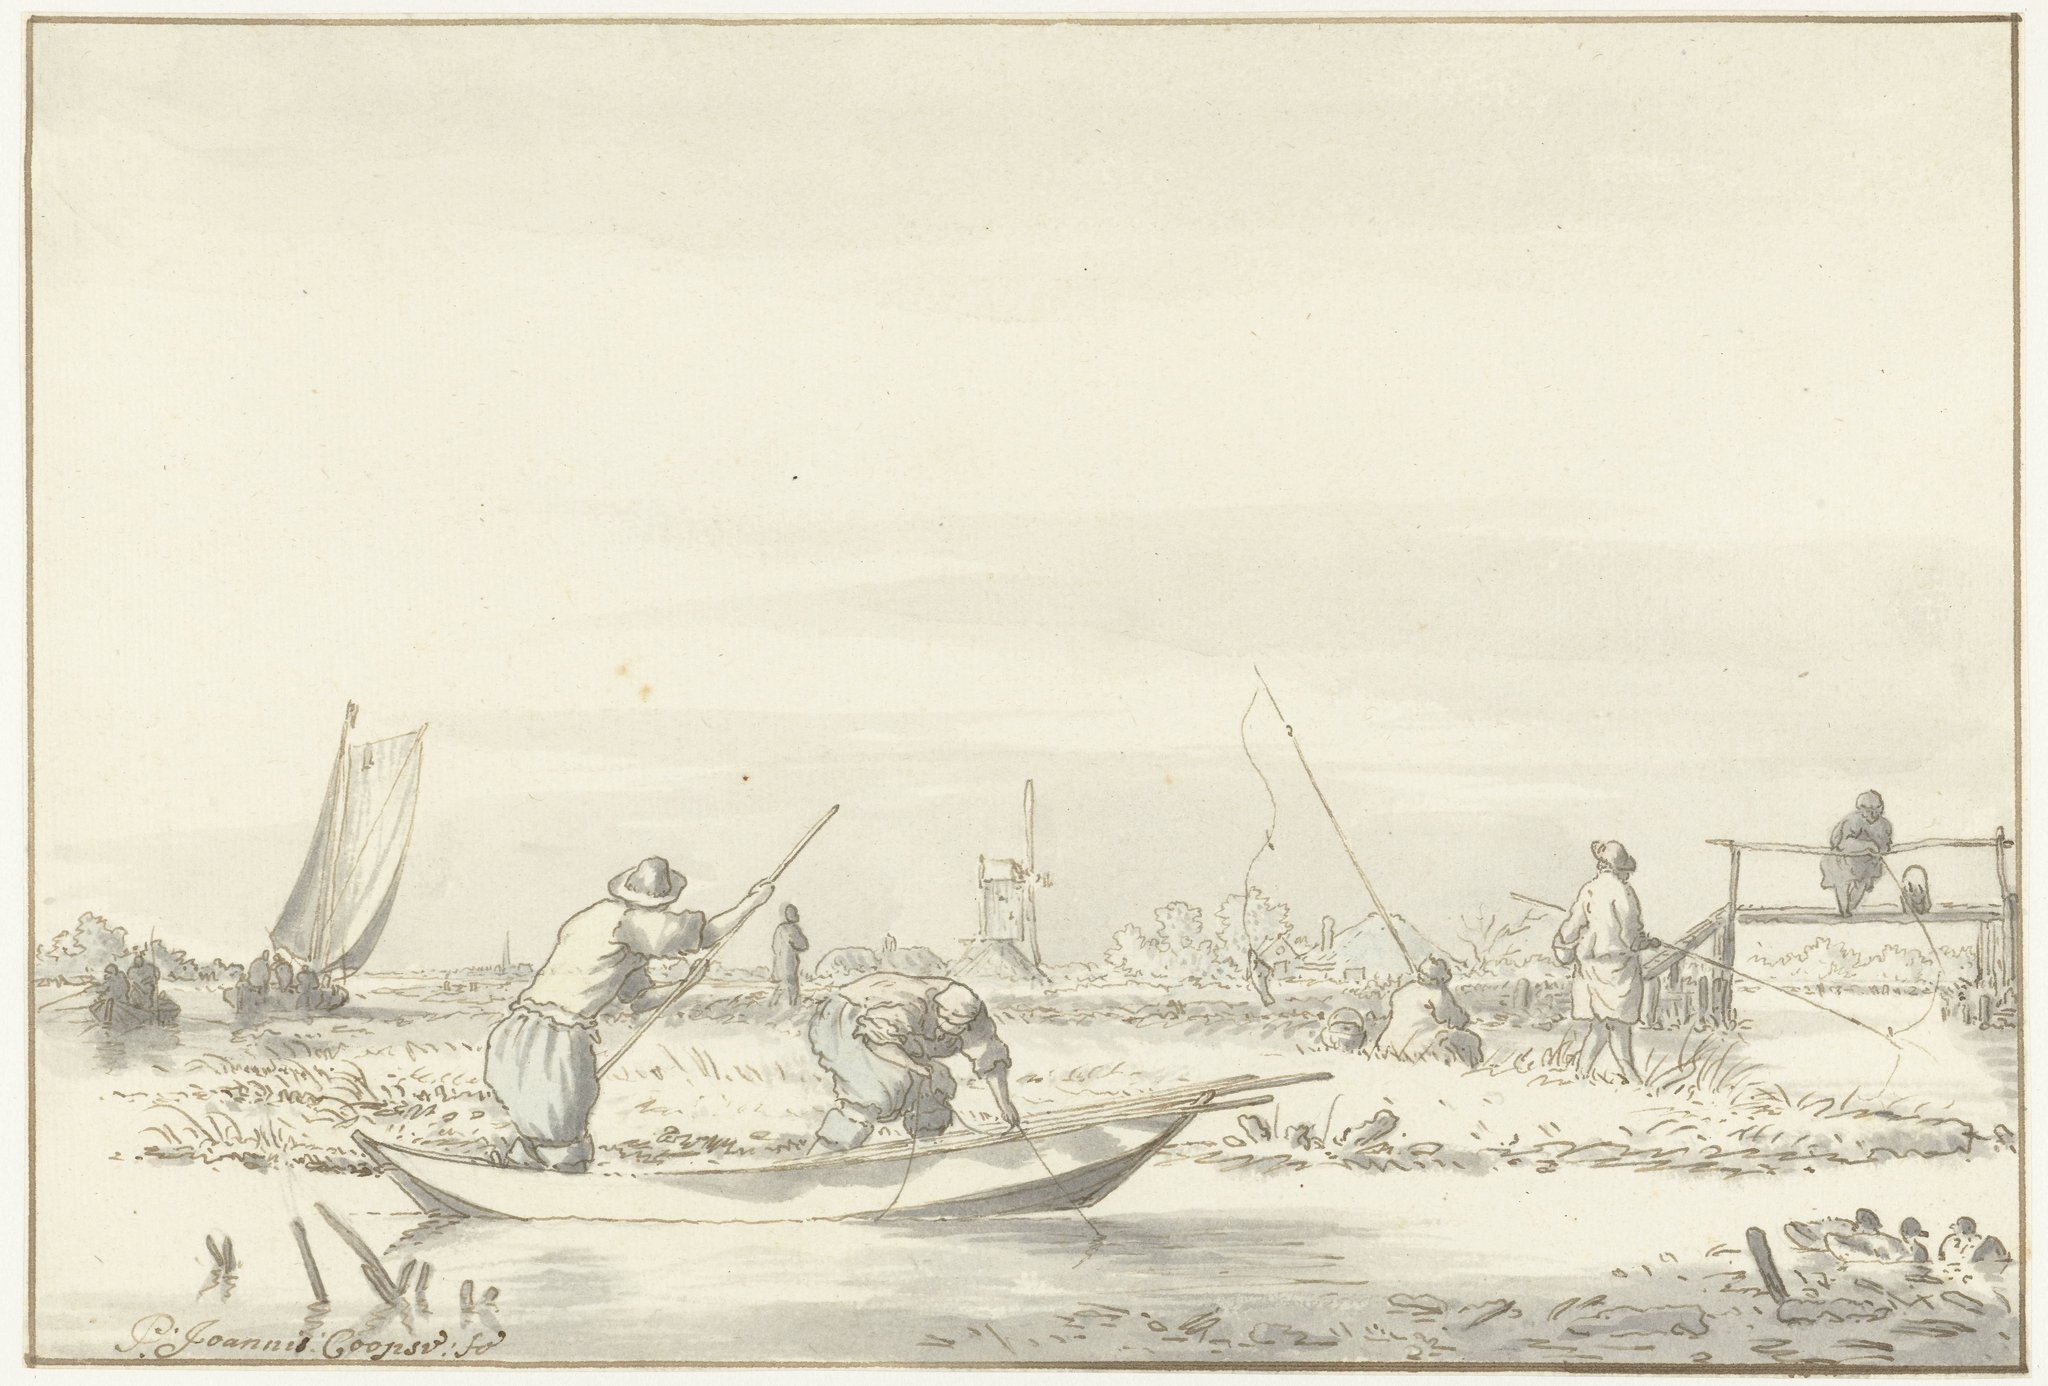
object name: drawing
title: Polderlandschap met vissers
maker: pieter coopse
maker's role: draughtsman, print maker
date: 1668-1677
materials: ink, paper, watercolor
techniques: brush, pen